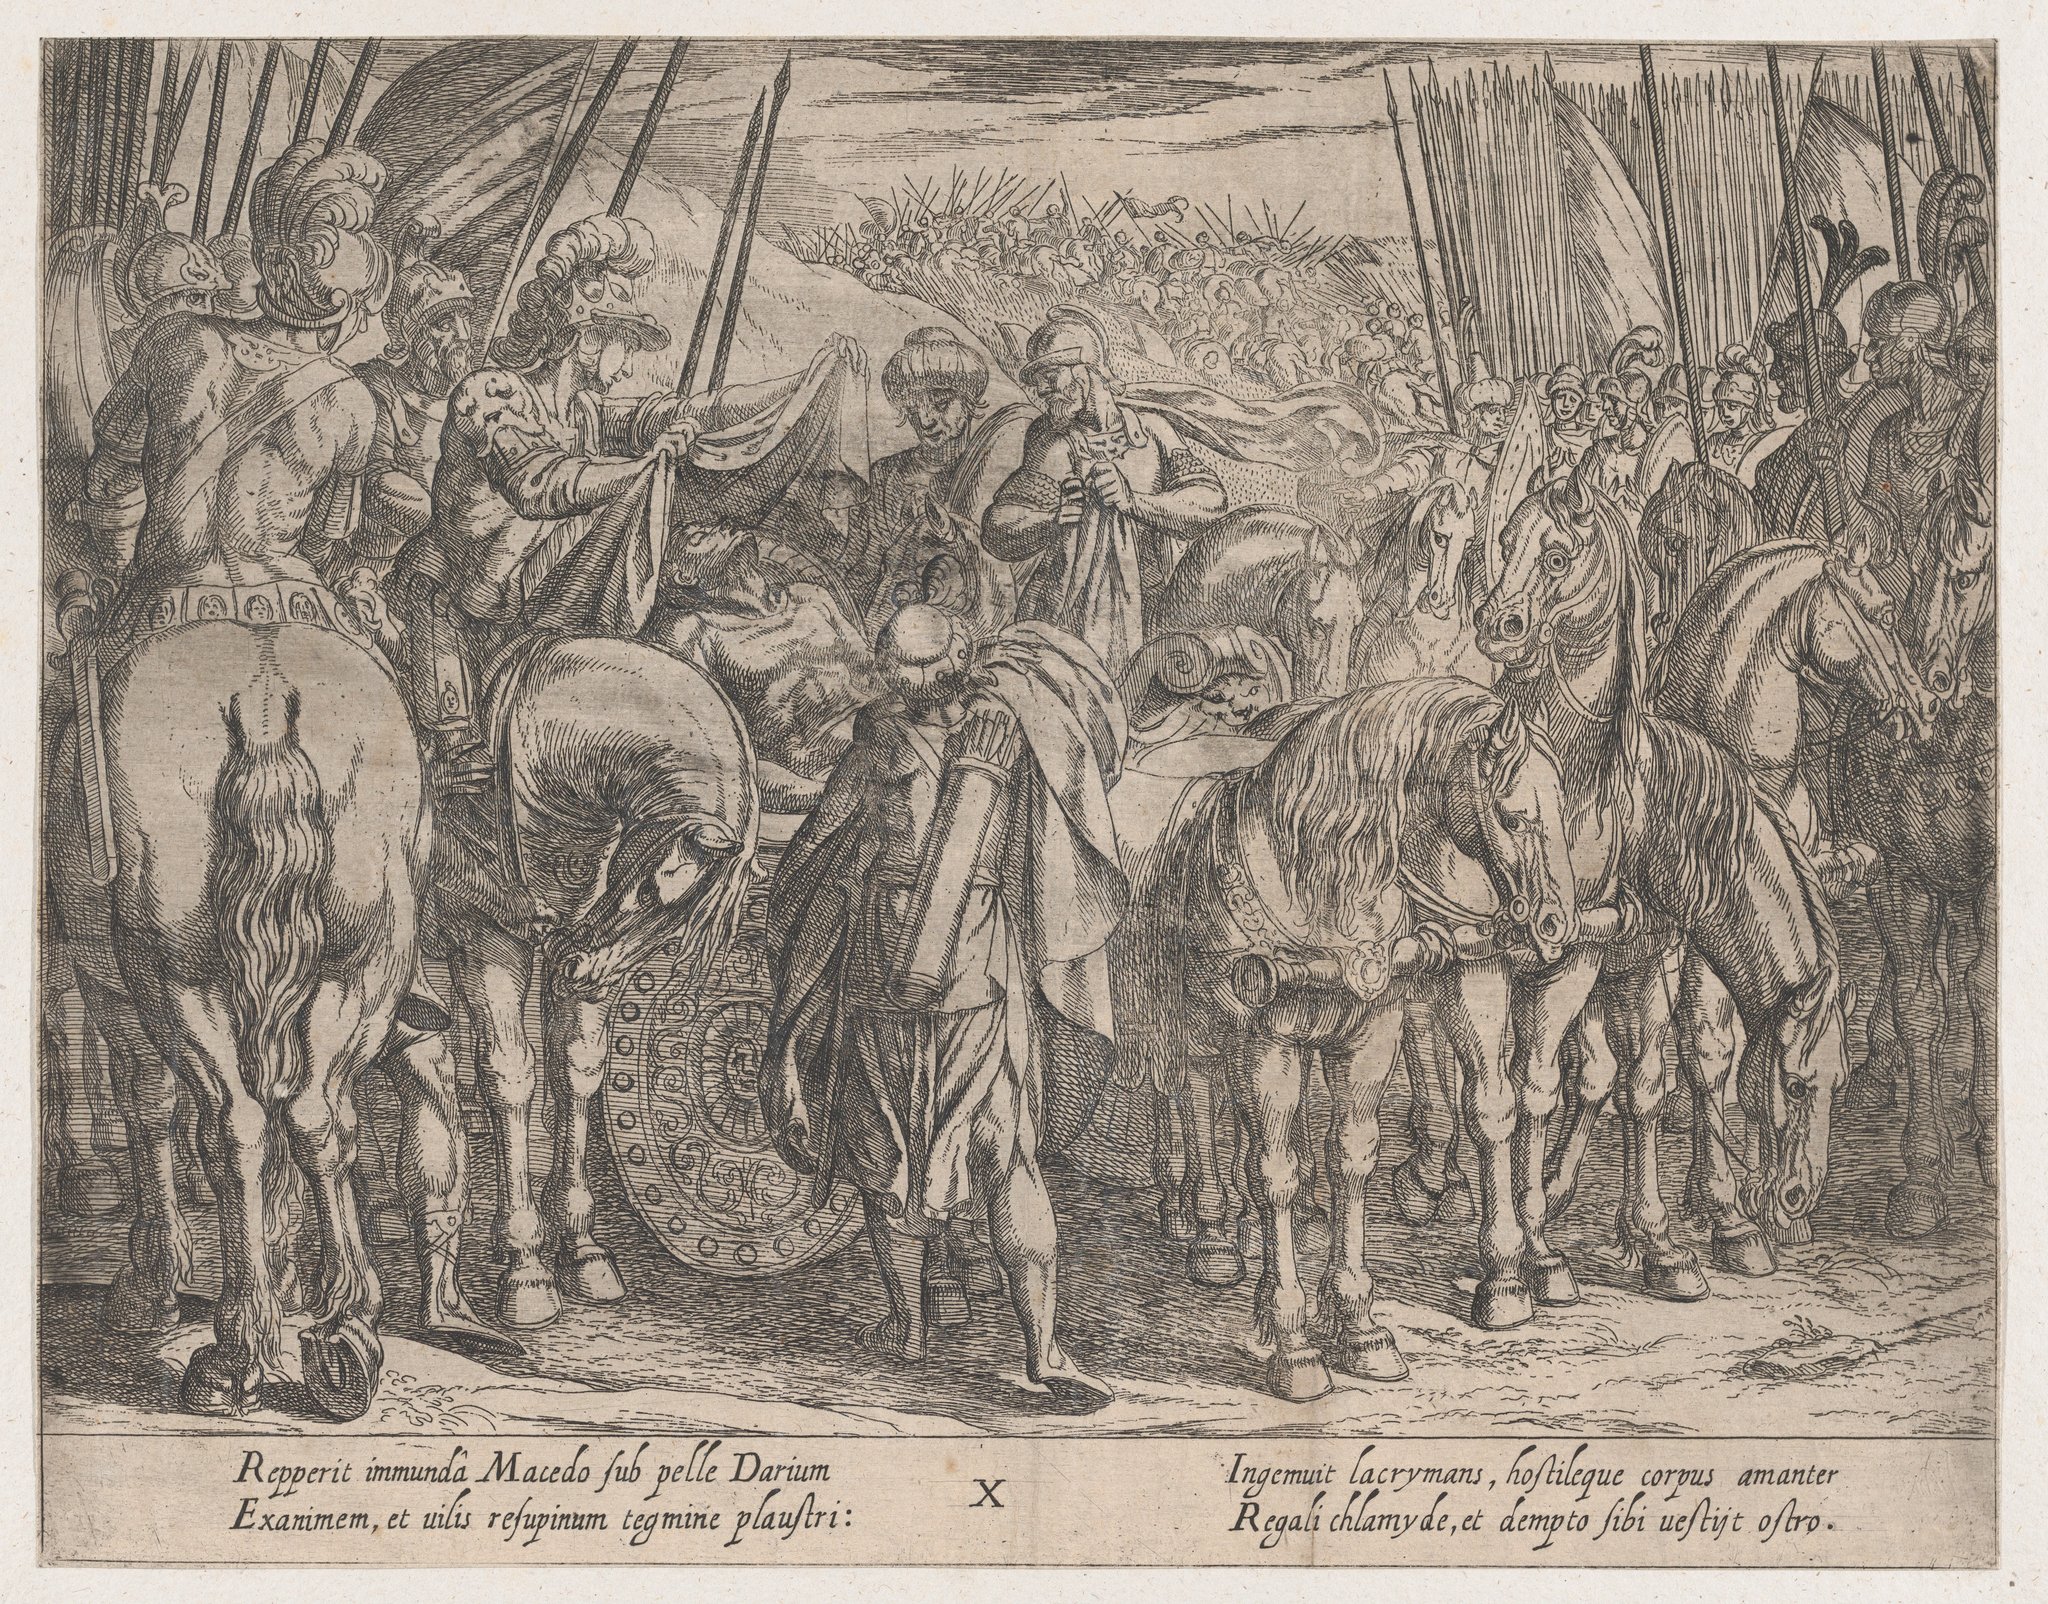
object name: print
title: Plate 10: Alexander Finding the Body of Darius, from "The Deeds of Alexander the Great"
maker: antonio tempesta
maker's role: artist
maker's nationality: italian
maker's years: 1555-1630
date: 1608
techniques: etching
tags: soldiers,alexander the great,men,horses